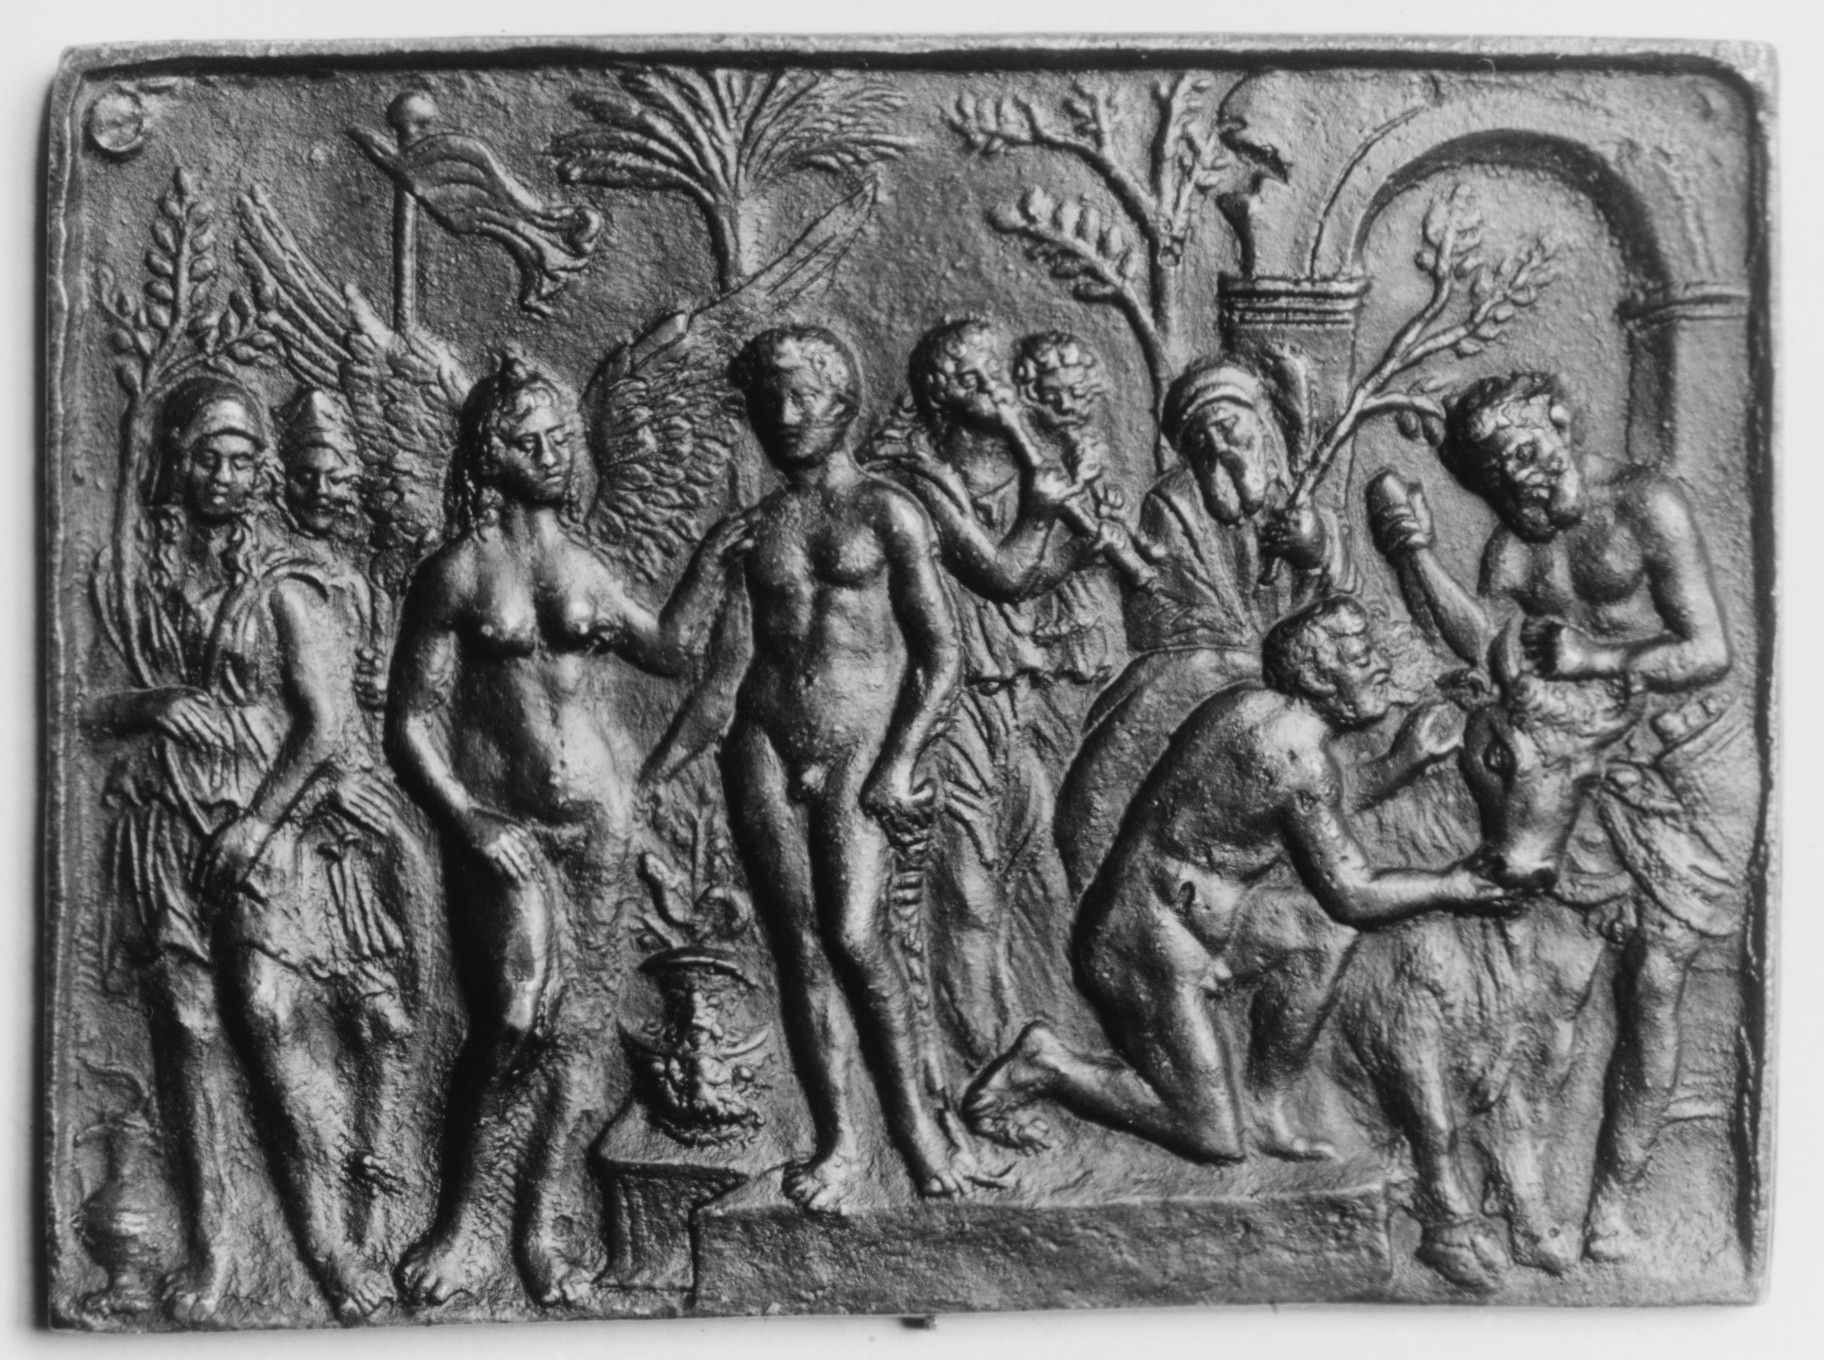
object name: plaquette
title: The Triumph of a Hero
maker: andrea briosco, called riccio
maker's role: artist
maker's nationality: italian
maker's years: 1470-1532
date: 1501-1533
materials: bronze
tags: animals,men,male nudes,female nudes